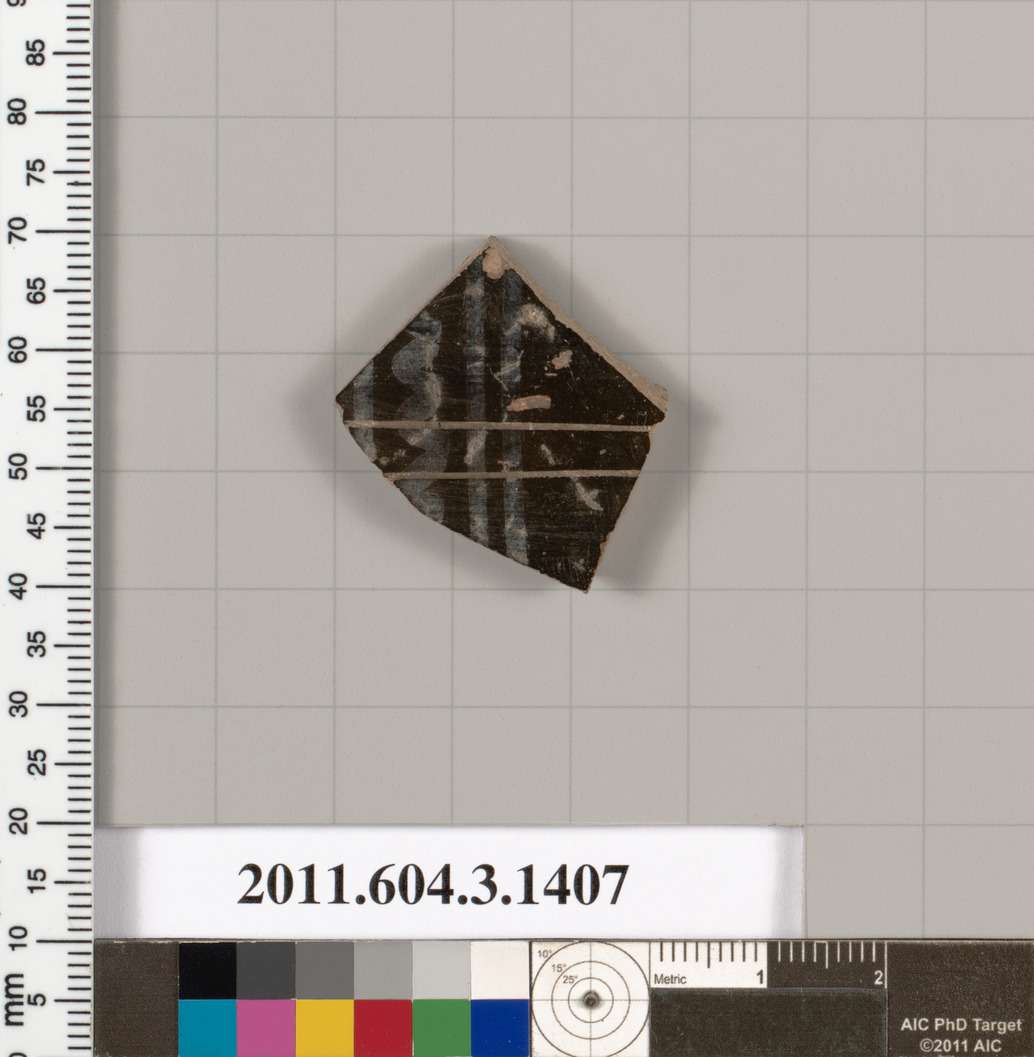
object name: skyphos fragment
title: Terracotta fragment of a skyphos (deep drinking cup)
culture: greek, attic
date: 534-468 BCE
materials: terracotta